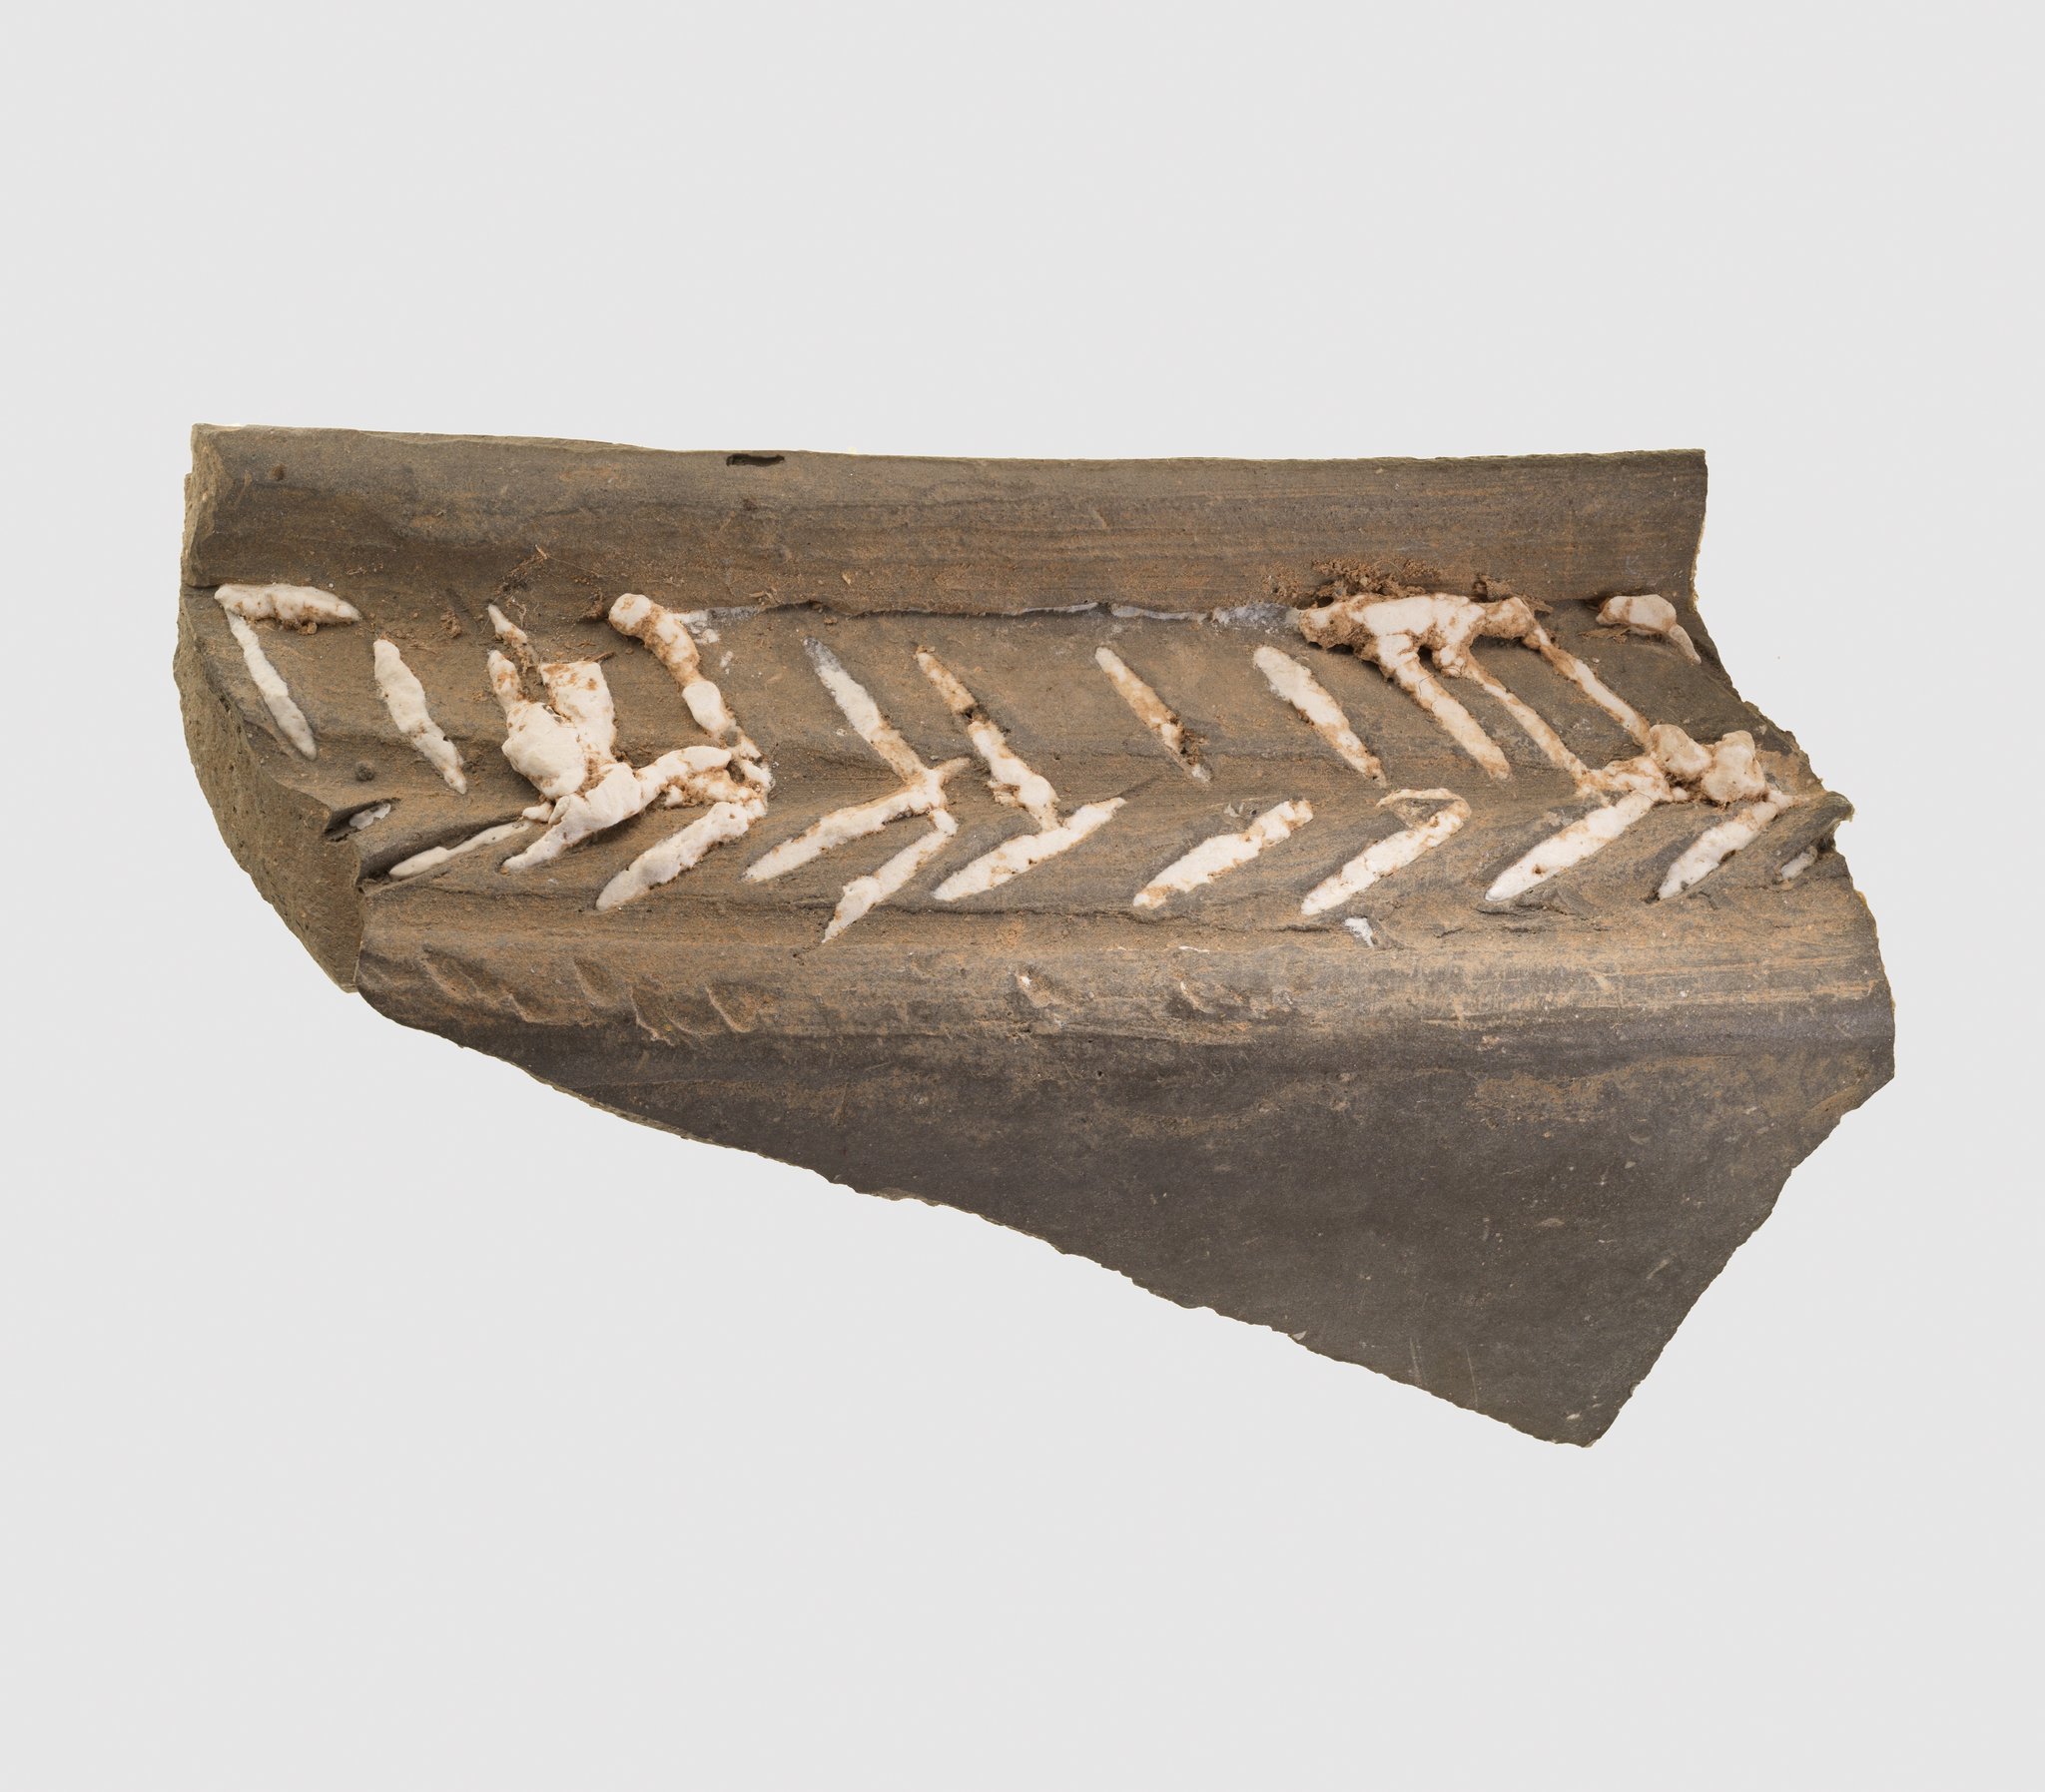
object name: bowl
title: Carinated bowl rim sherd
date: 2333-2001 BCE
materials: ceramic, gypsum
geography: mesopotamia